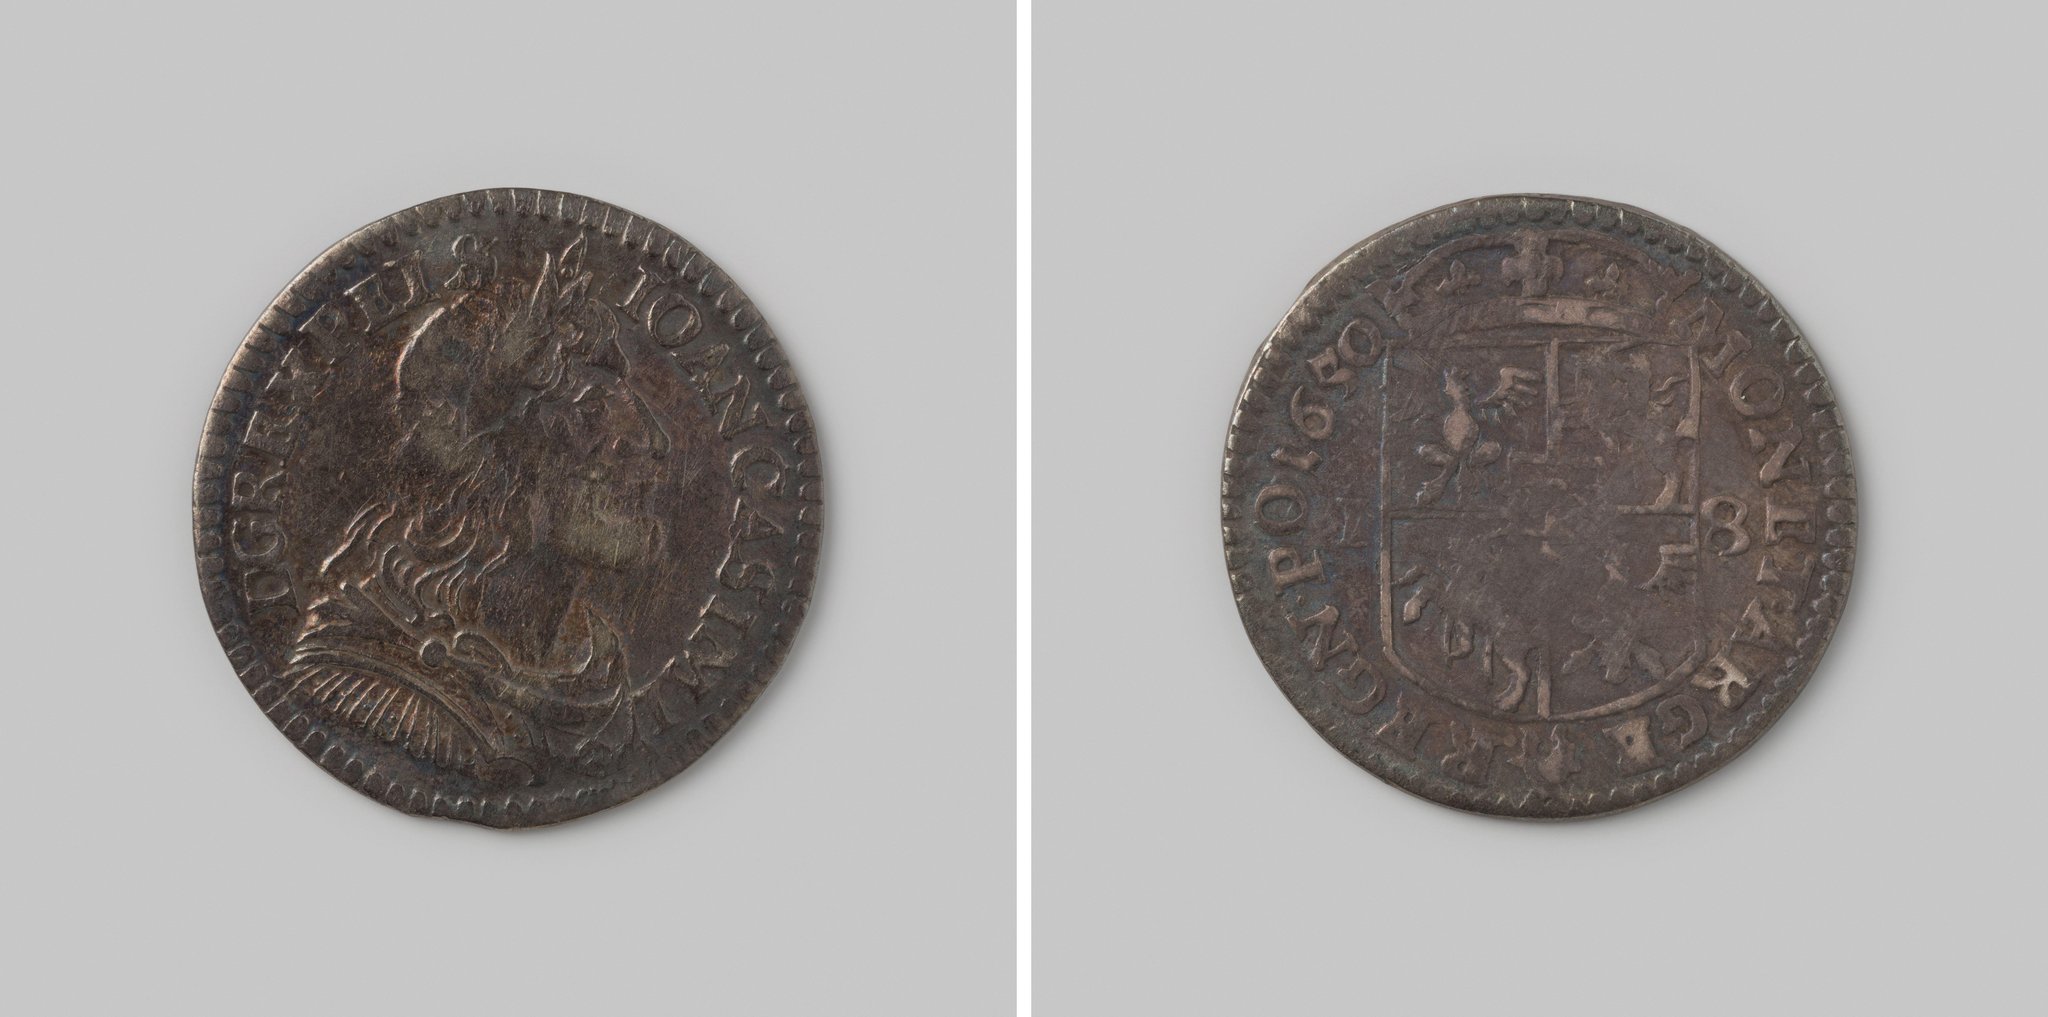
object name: coin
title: Polen, Jan II Kazimiérz, ort of 18 groschen, 1650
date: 1650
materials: silver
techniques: striking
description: Zilveren munt. Voorzijde: gelauwerd borstbeeld van de vorst naar rechts. Keerzijde: tussen waarde-aanduiding 1 8 gekroond wapenschild. Jaartal aan het eind van het omschrift.